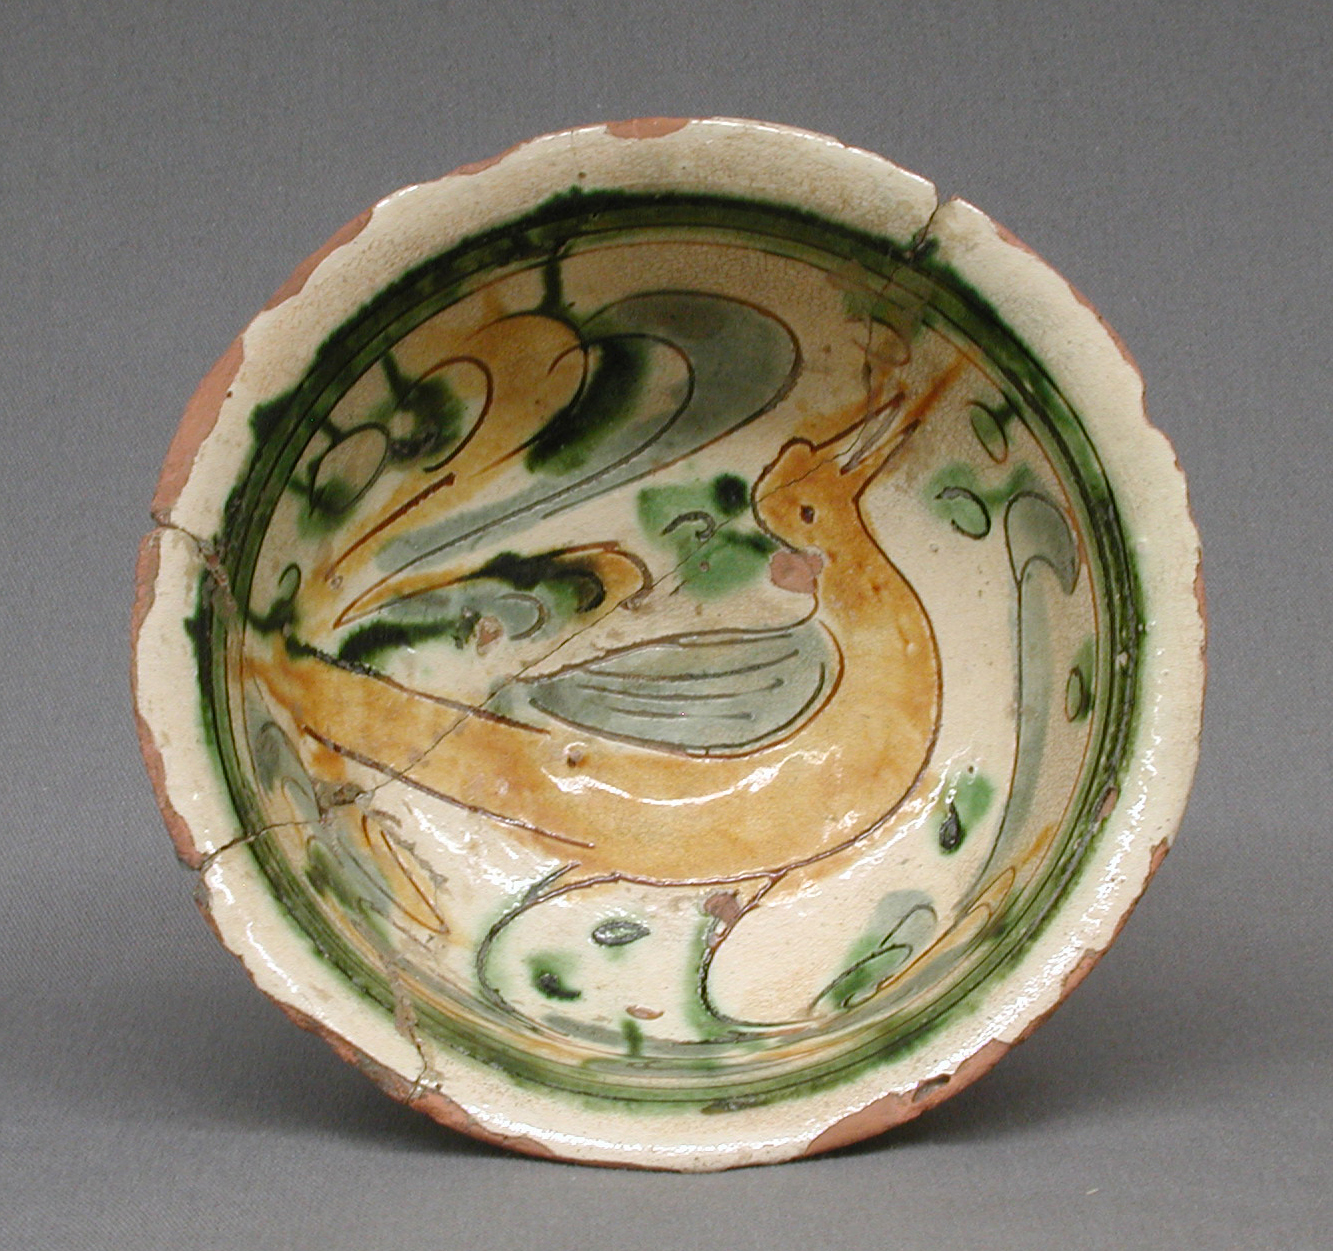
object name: bowl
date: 1401-1600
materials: earthenware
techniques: glazing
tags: birds